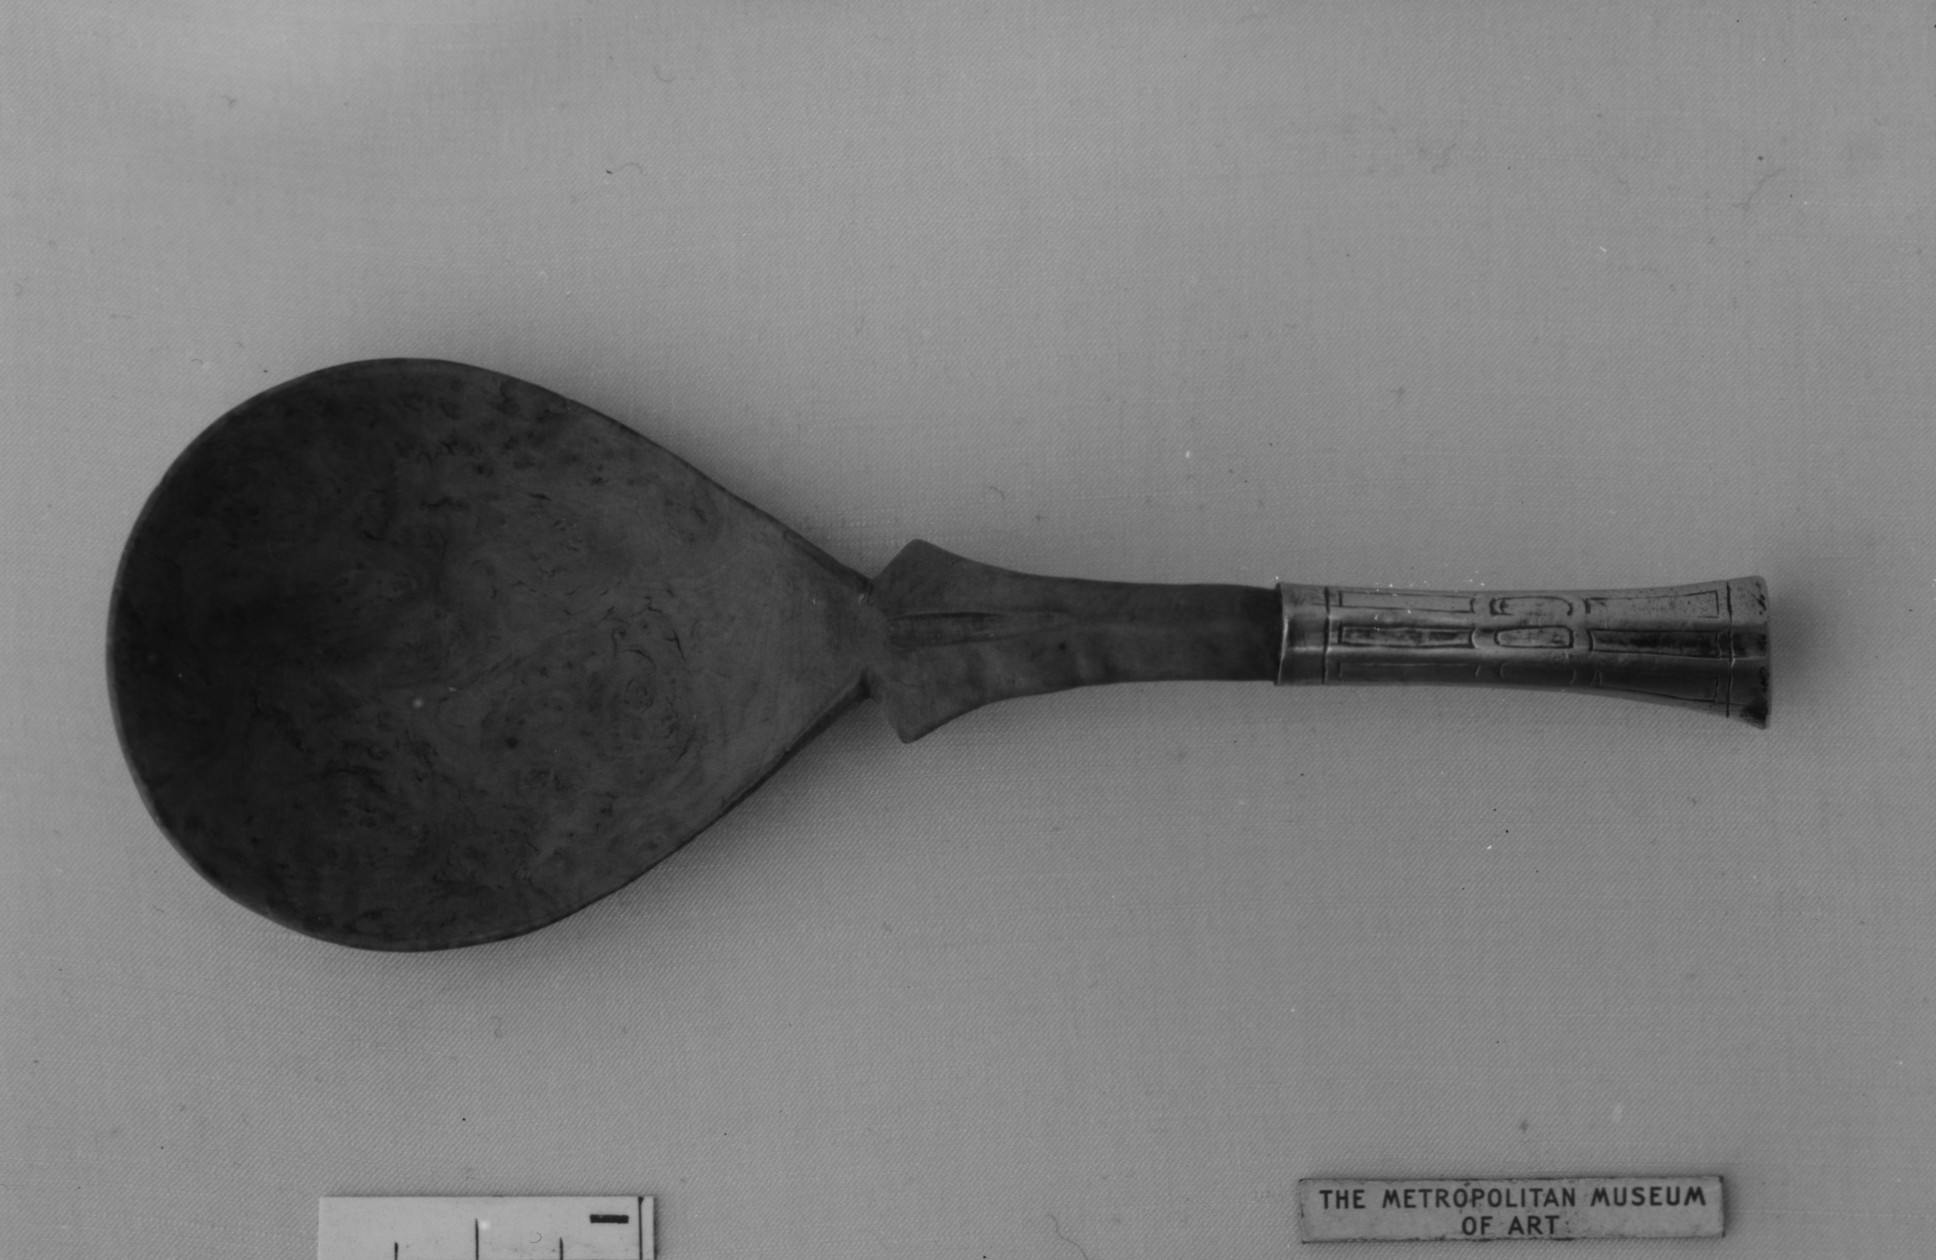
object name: spoon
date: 1551-1600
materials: silver, wood